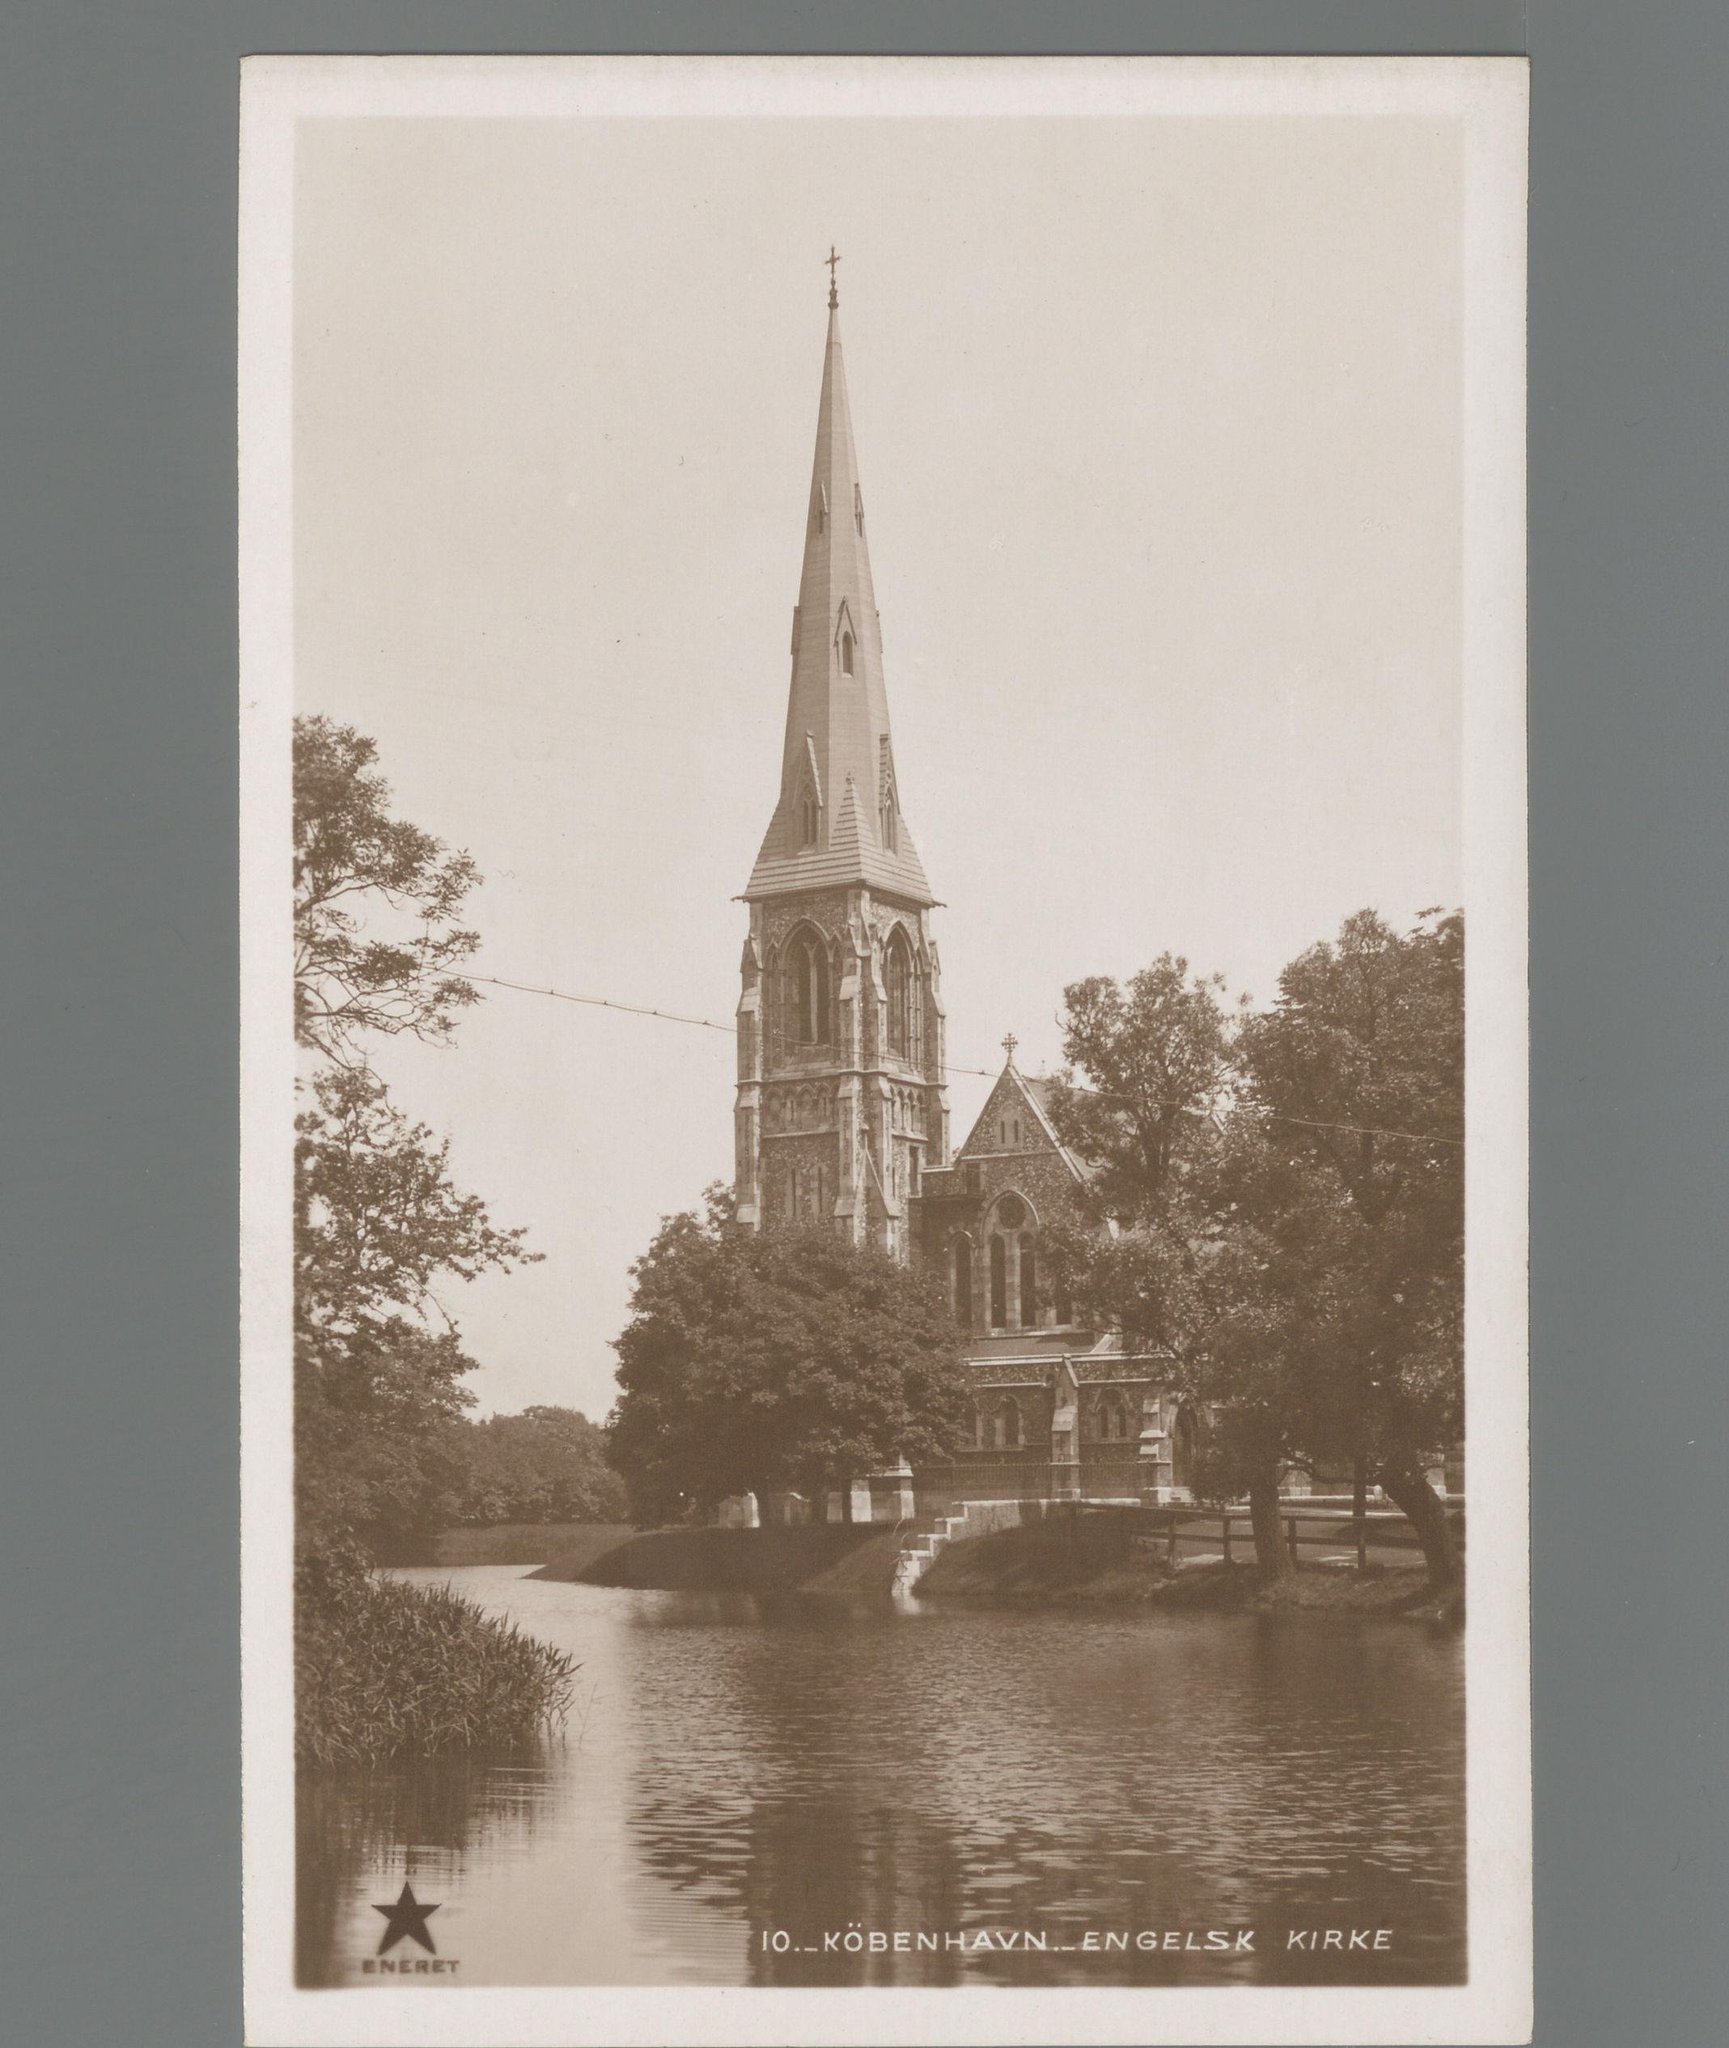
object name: ansichtkaart, prentbriefkaart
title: Köbenhavn. Engelsk Kirke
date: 1906-1920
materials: photographic support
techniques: photography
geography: copenhagen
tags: church (exterior), public gardens, park, copenhagen (city)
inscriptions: mark